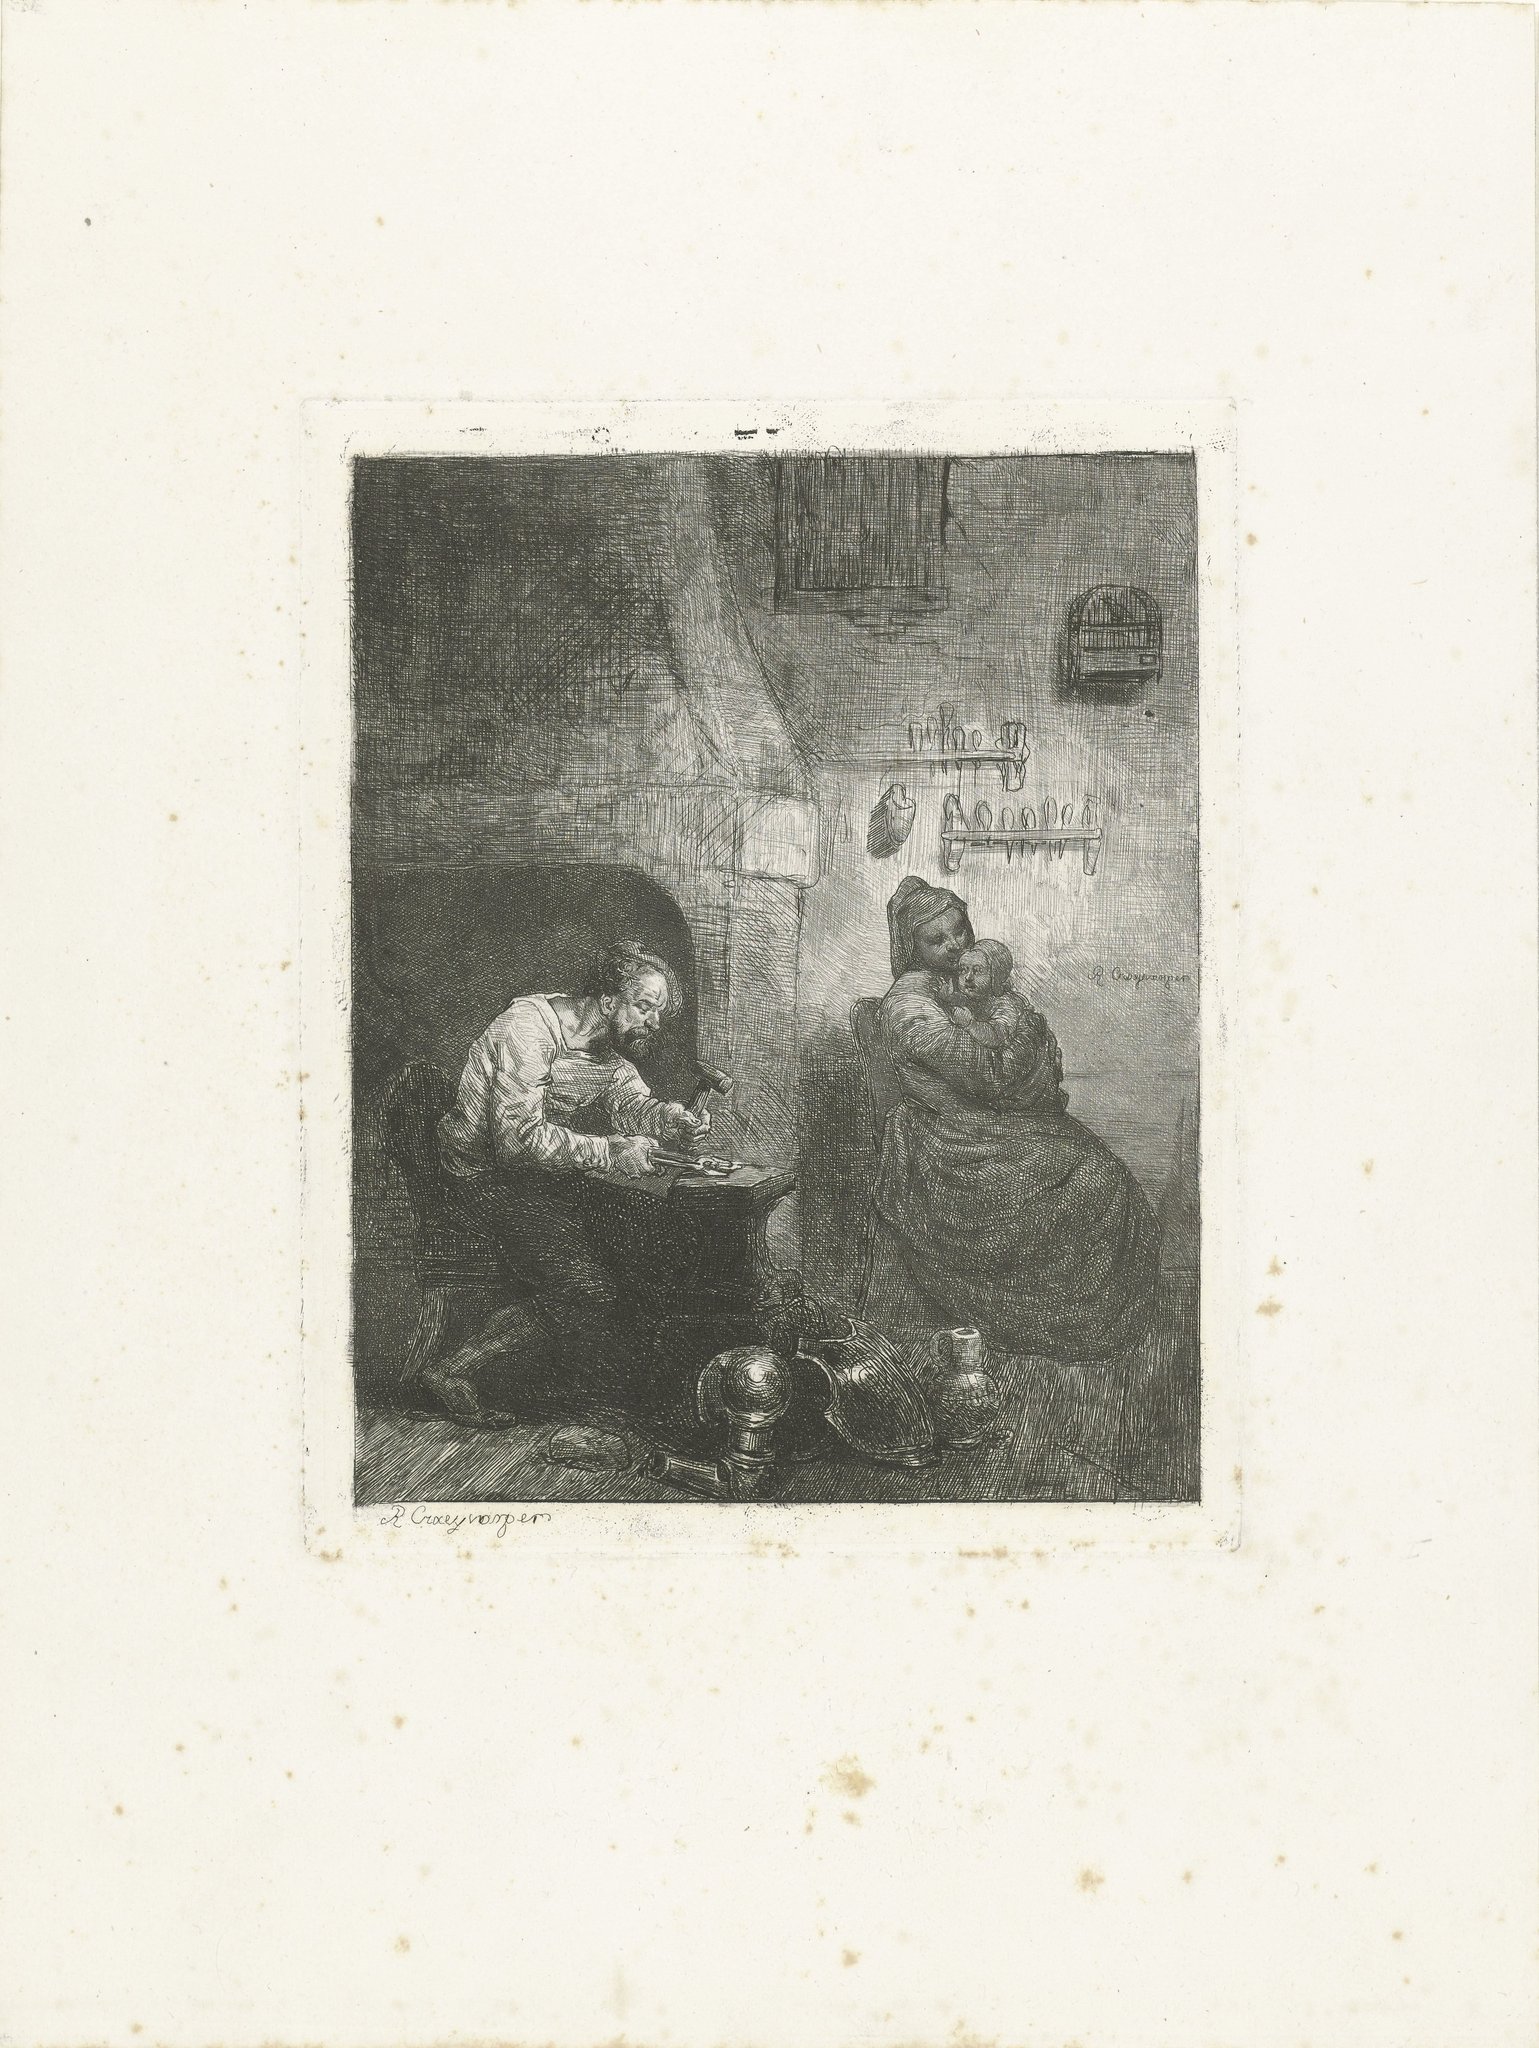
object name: print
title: Wapensmid aan het werk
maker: reinier craeyvanger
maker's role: draughtsman, print maker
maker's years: 1812-1880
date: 1822-1880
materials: paper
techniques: etching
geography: amsterdam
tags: smith, blacksmith (+ indoors; in laboratory, factory, barn, etc.), armour, mother and baby or young child, handicrafts ~ metal, forging (industrial process)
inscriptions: collector's mark: Lugt 2228, collector's mark: Lugt 2166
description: Een wapensmid zit op een stoel voor een aambeeld en bewerkt met een hamer een voorwerp dat hij in een tang vasthoudt. Naast het aambeeld liggen delen van een harnas. Achter hem een haard. Rechts zit zijn vrouw met een kind in de armen.